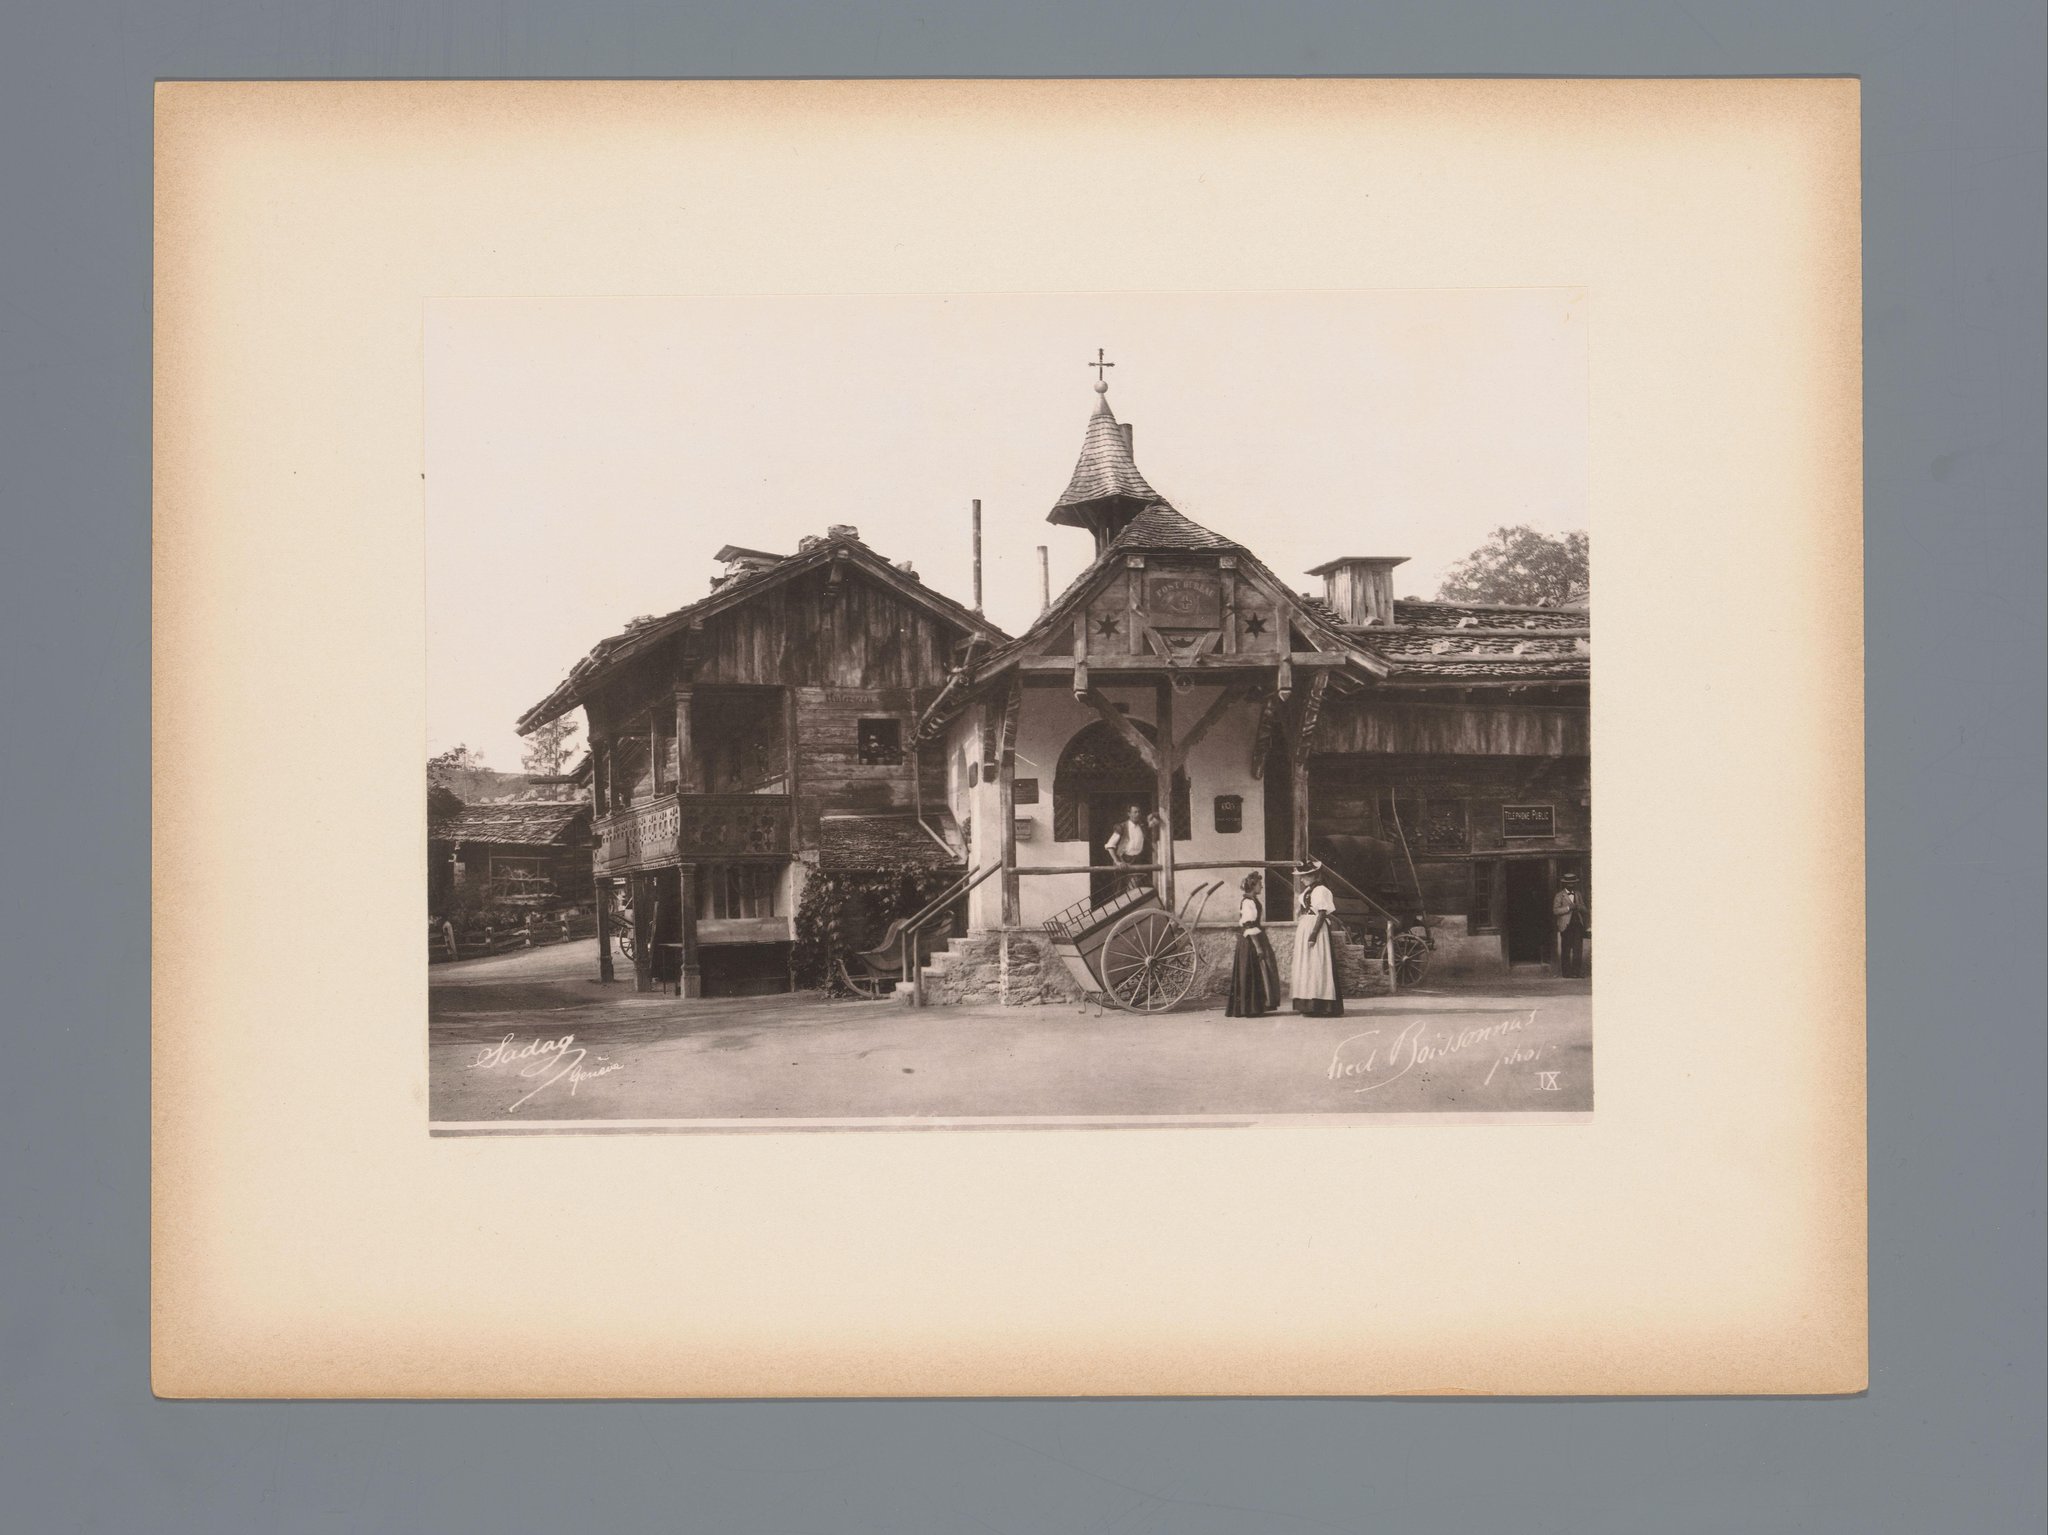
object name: page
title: Dorpsgezicht in Zwitserland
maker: frédéric boissonnas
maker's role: fotograaf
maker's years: 1858-1946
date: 1891-1896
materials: paper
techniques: photograph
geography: switzerland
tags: street (+ city(-scape) with figures, staffage), switzerland